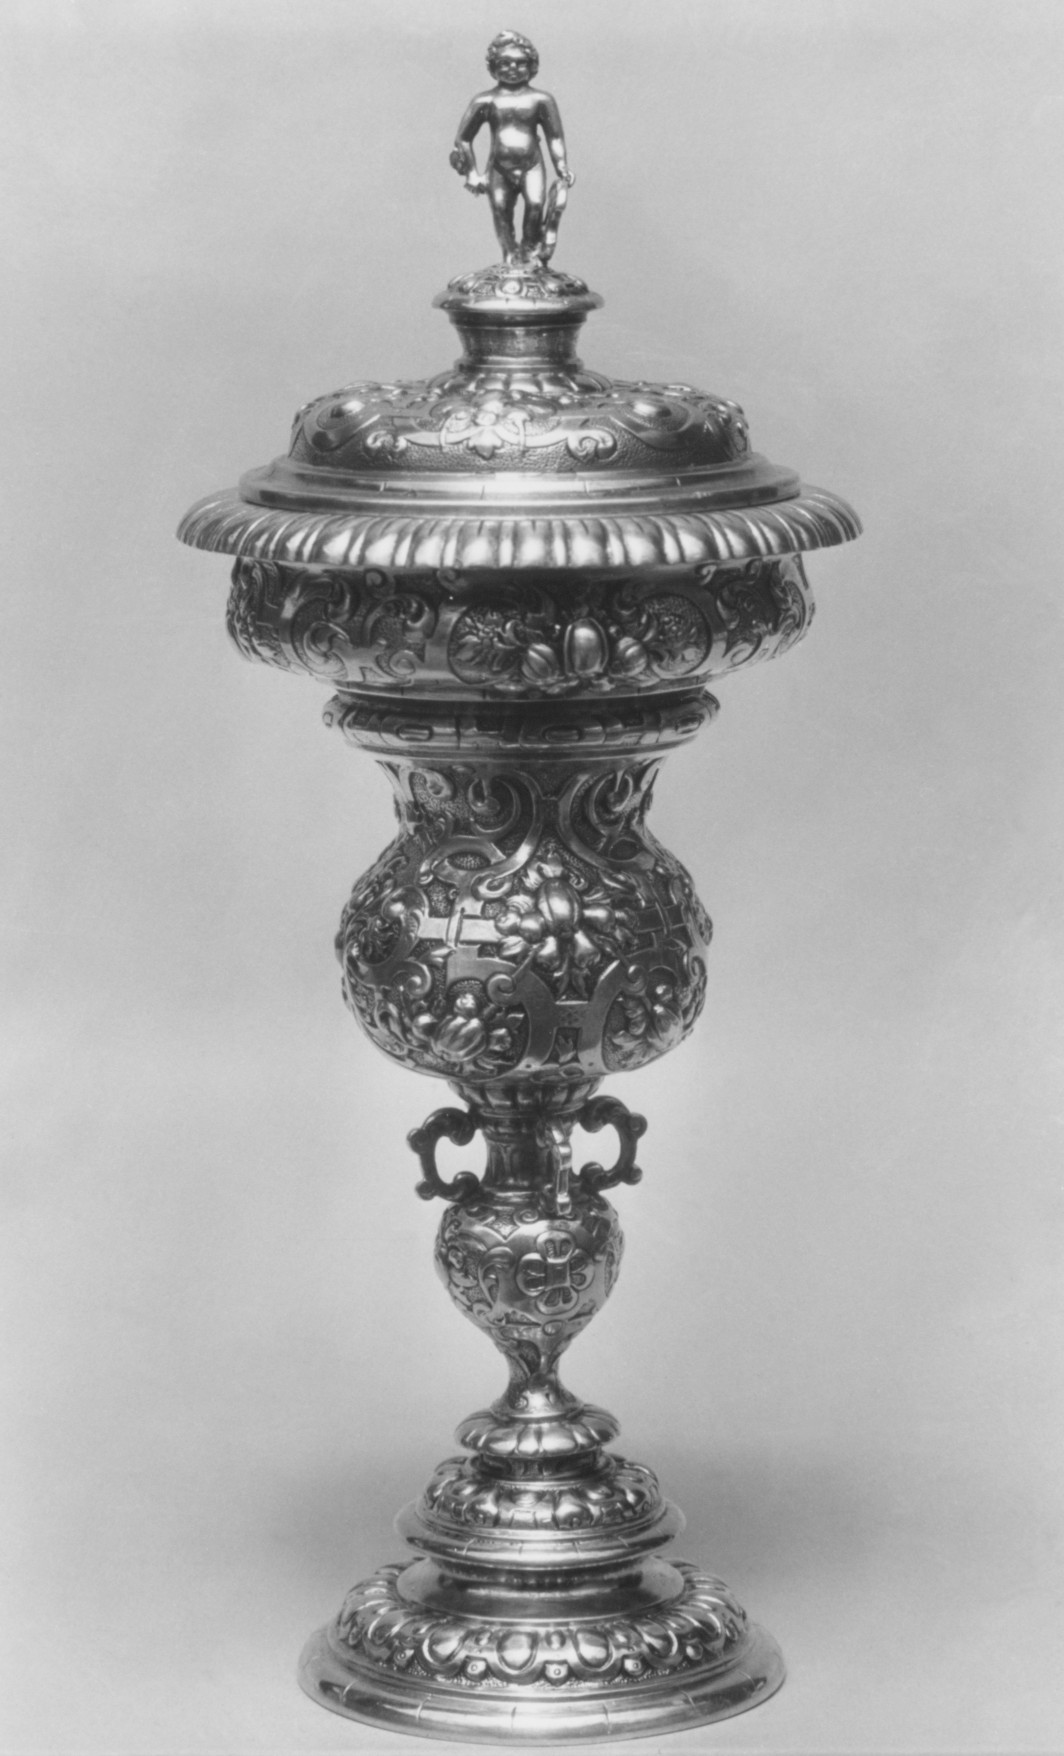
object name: cup with cover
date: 1601-1700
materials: silver gilt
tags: male nudes